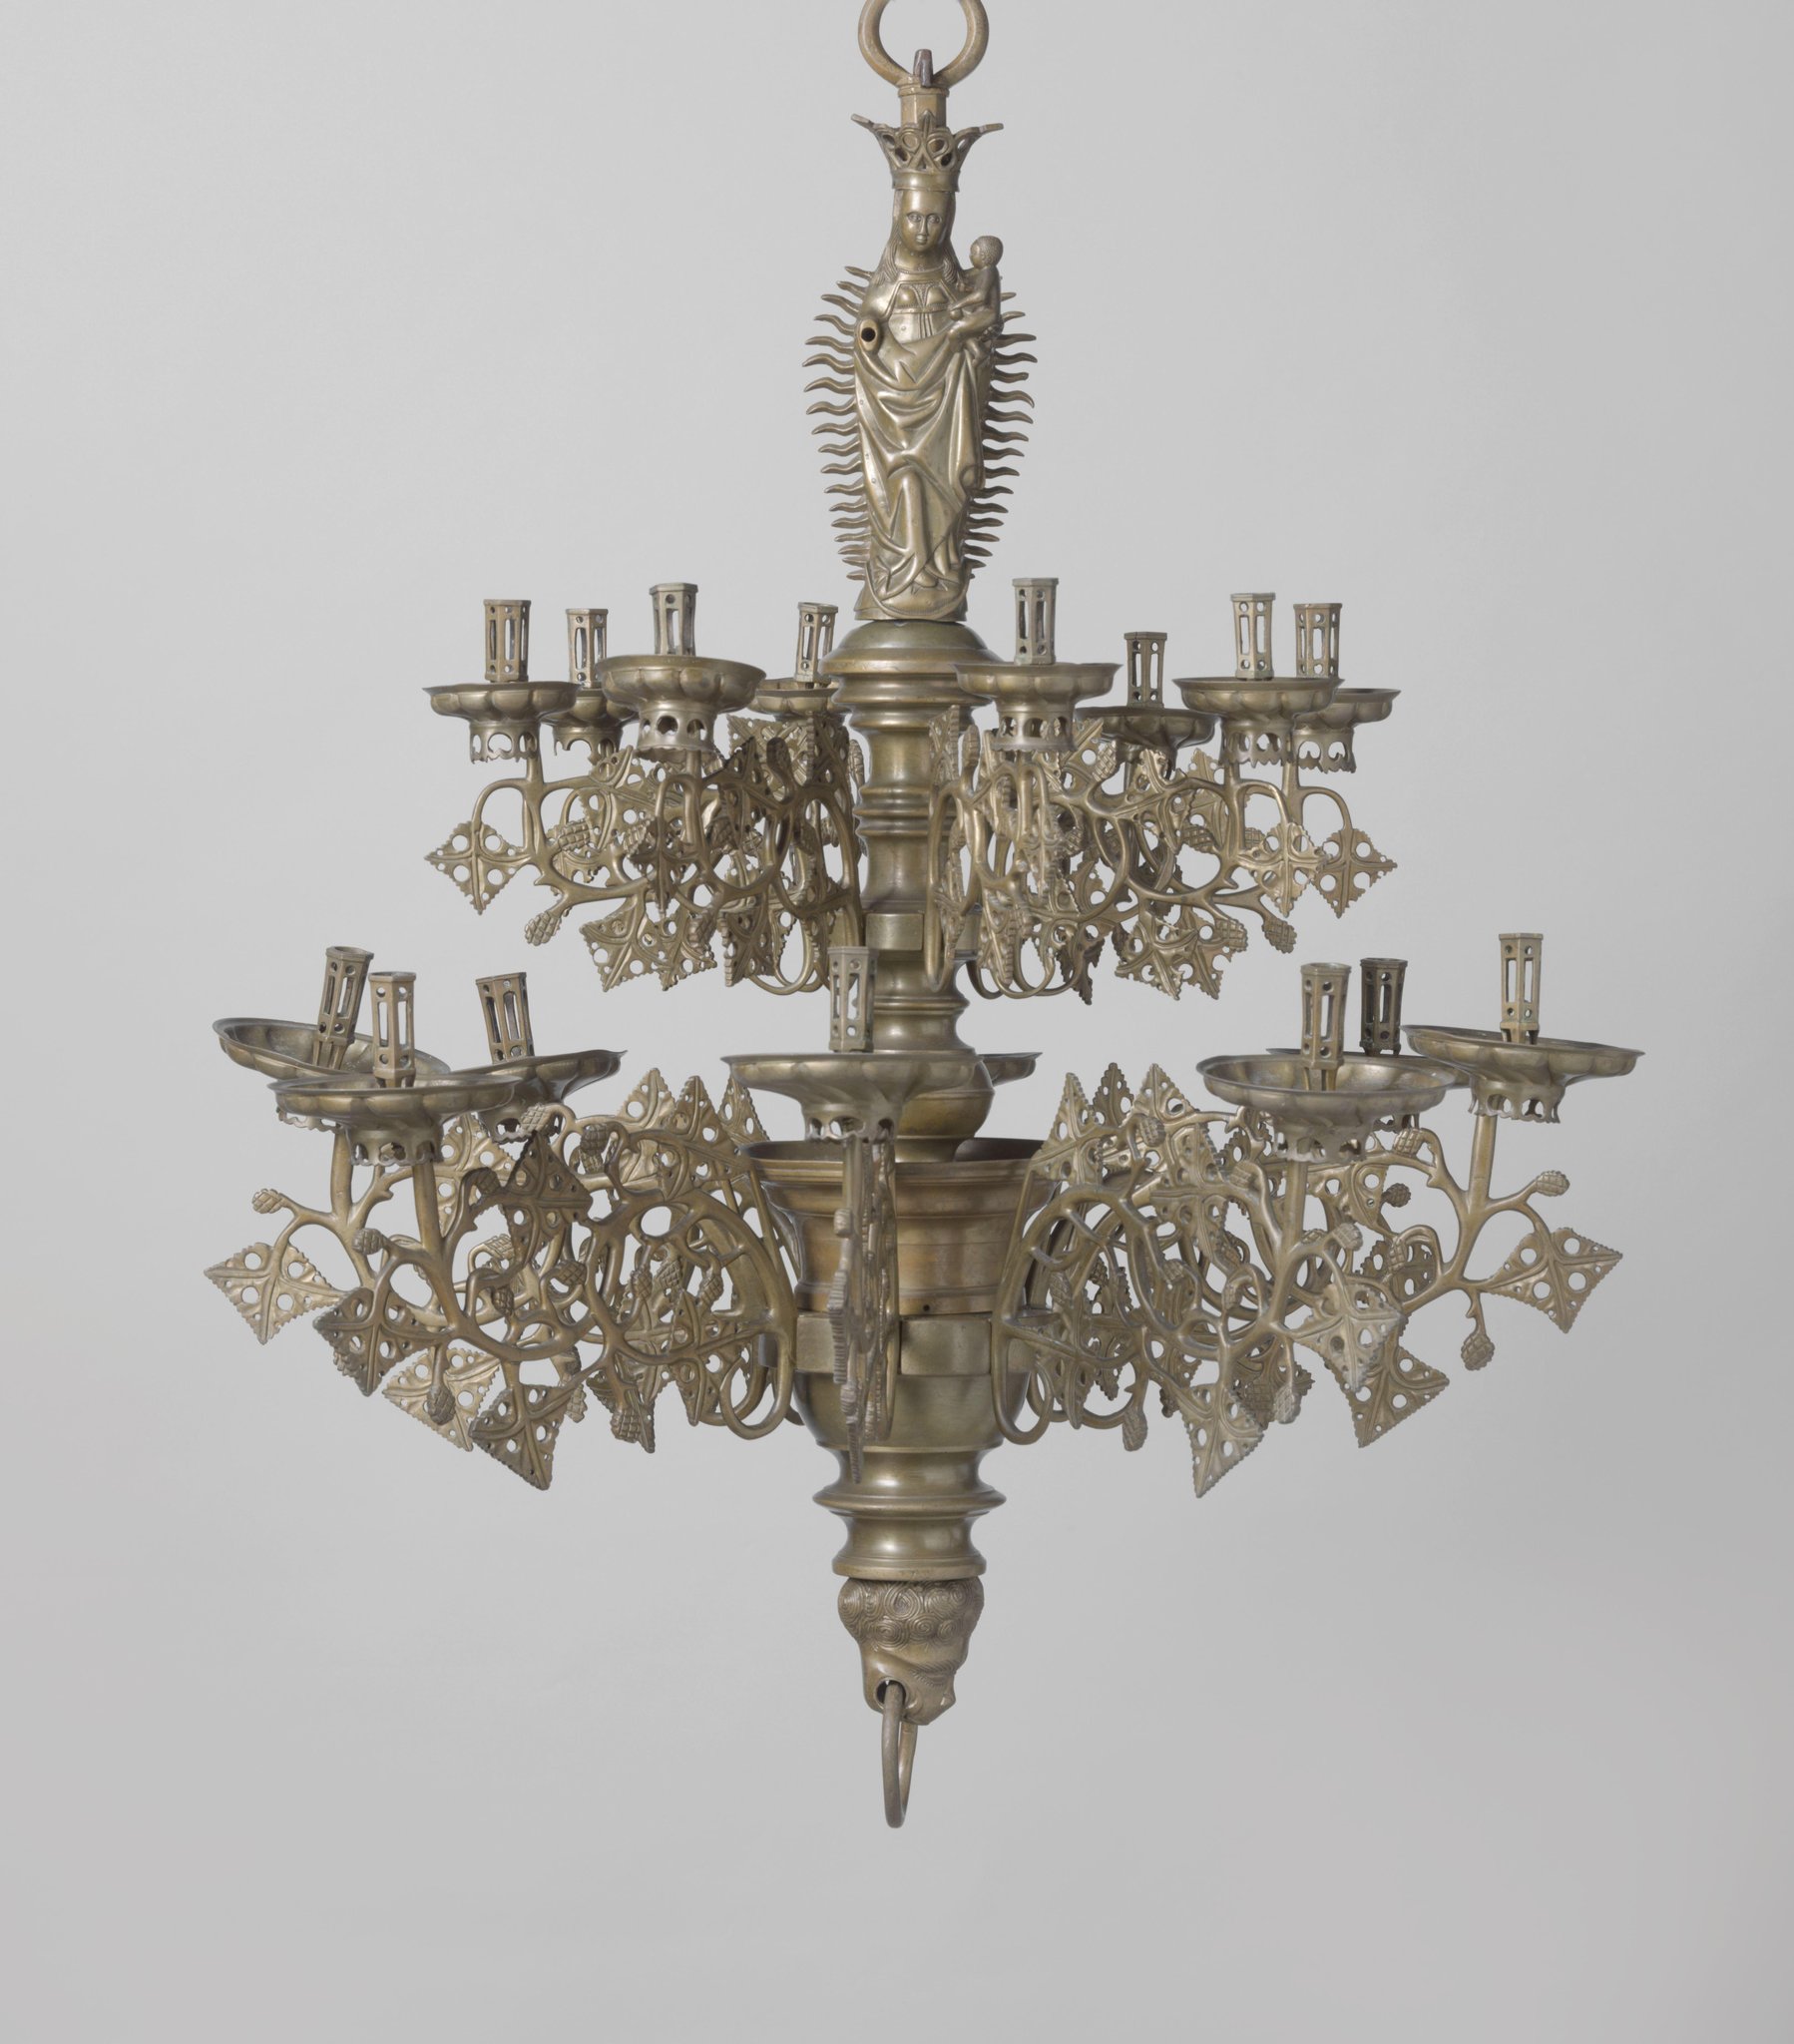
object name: chandelier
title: Arm met kaarsenhouder van kaarsenkroon van twee hoogten met ieder acht armen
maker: Anonymous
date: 1525-1550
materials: brass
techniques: casting, screwed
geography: southern netherlands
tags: vine-tendril, leaf, mary standing (or half-length), the christ-child sitting on her arm (christ-child to mary's left)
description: Kaarsenarm behorende bij een kaarsenkroon van twee hoogten met Mariafiguur bovenaan. De arm is twee maal gebogen en is versierd met vier druiventrossen en vijf wingerdbladeren. De ronde vetvanger is aan de onderkant versierd met visblaasmotieven en heeft naar het midden toe een naar beneden uitstekende rand van kruisbloemen, die de plaatsing op de arm maskeert. De kaarsenhouder is zesvlakkig, opengewerkt, geplaatst op drie verticale stijlen, overgaande in een uitsteeksel met schroefdraad. Dit is de eerste arm van de bovenste ring, genummerd met 1 ronde punt. De kaarsenhouder is genummerd met 1 diagonale inkeping.